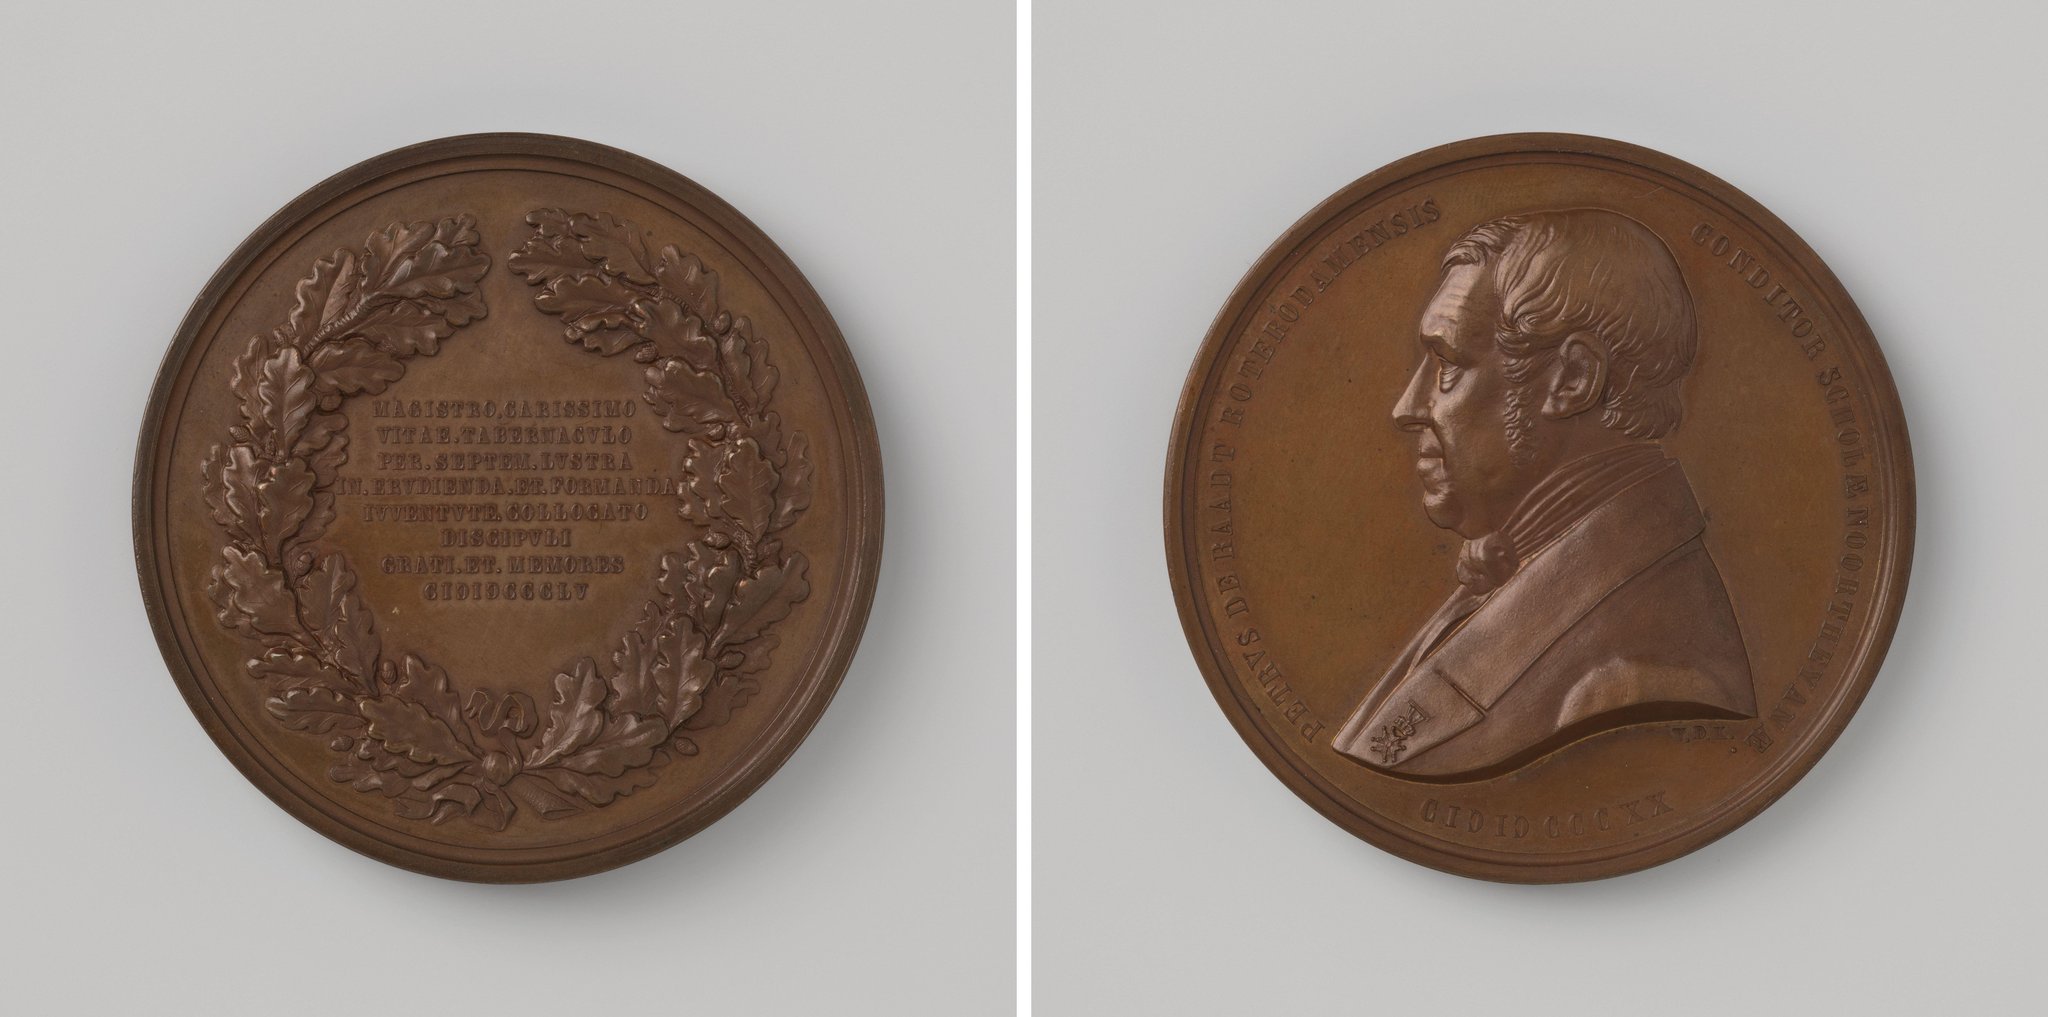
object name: history medal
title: Vijfendertigjarig bestaan van de School te Noordhey opgericht door Petrus de Raadt 1856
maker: david van der kellen (1804-1879)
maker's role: die cutter, draughtsman, print maker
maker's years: 1804-1879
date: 1856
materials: bronze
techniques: striking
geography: utrecht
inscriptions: inscription: ‘H. WILLINK 1833-36 LID DER COMMISSIE.’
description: Bronzen penning, op de voorzijde het borstbeeld van De Raadt naar links met omschrift, op de keerzijde acht regels tekst tussen samengestrikte eikentakken. Met randinscriptie op naam.